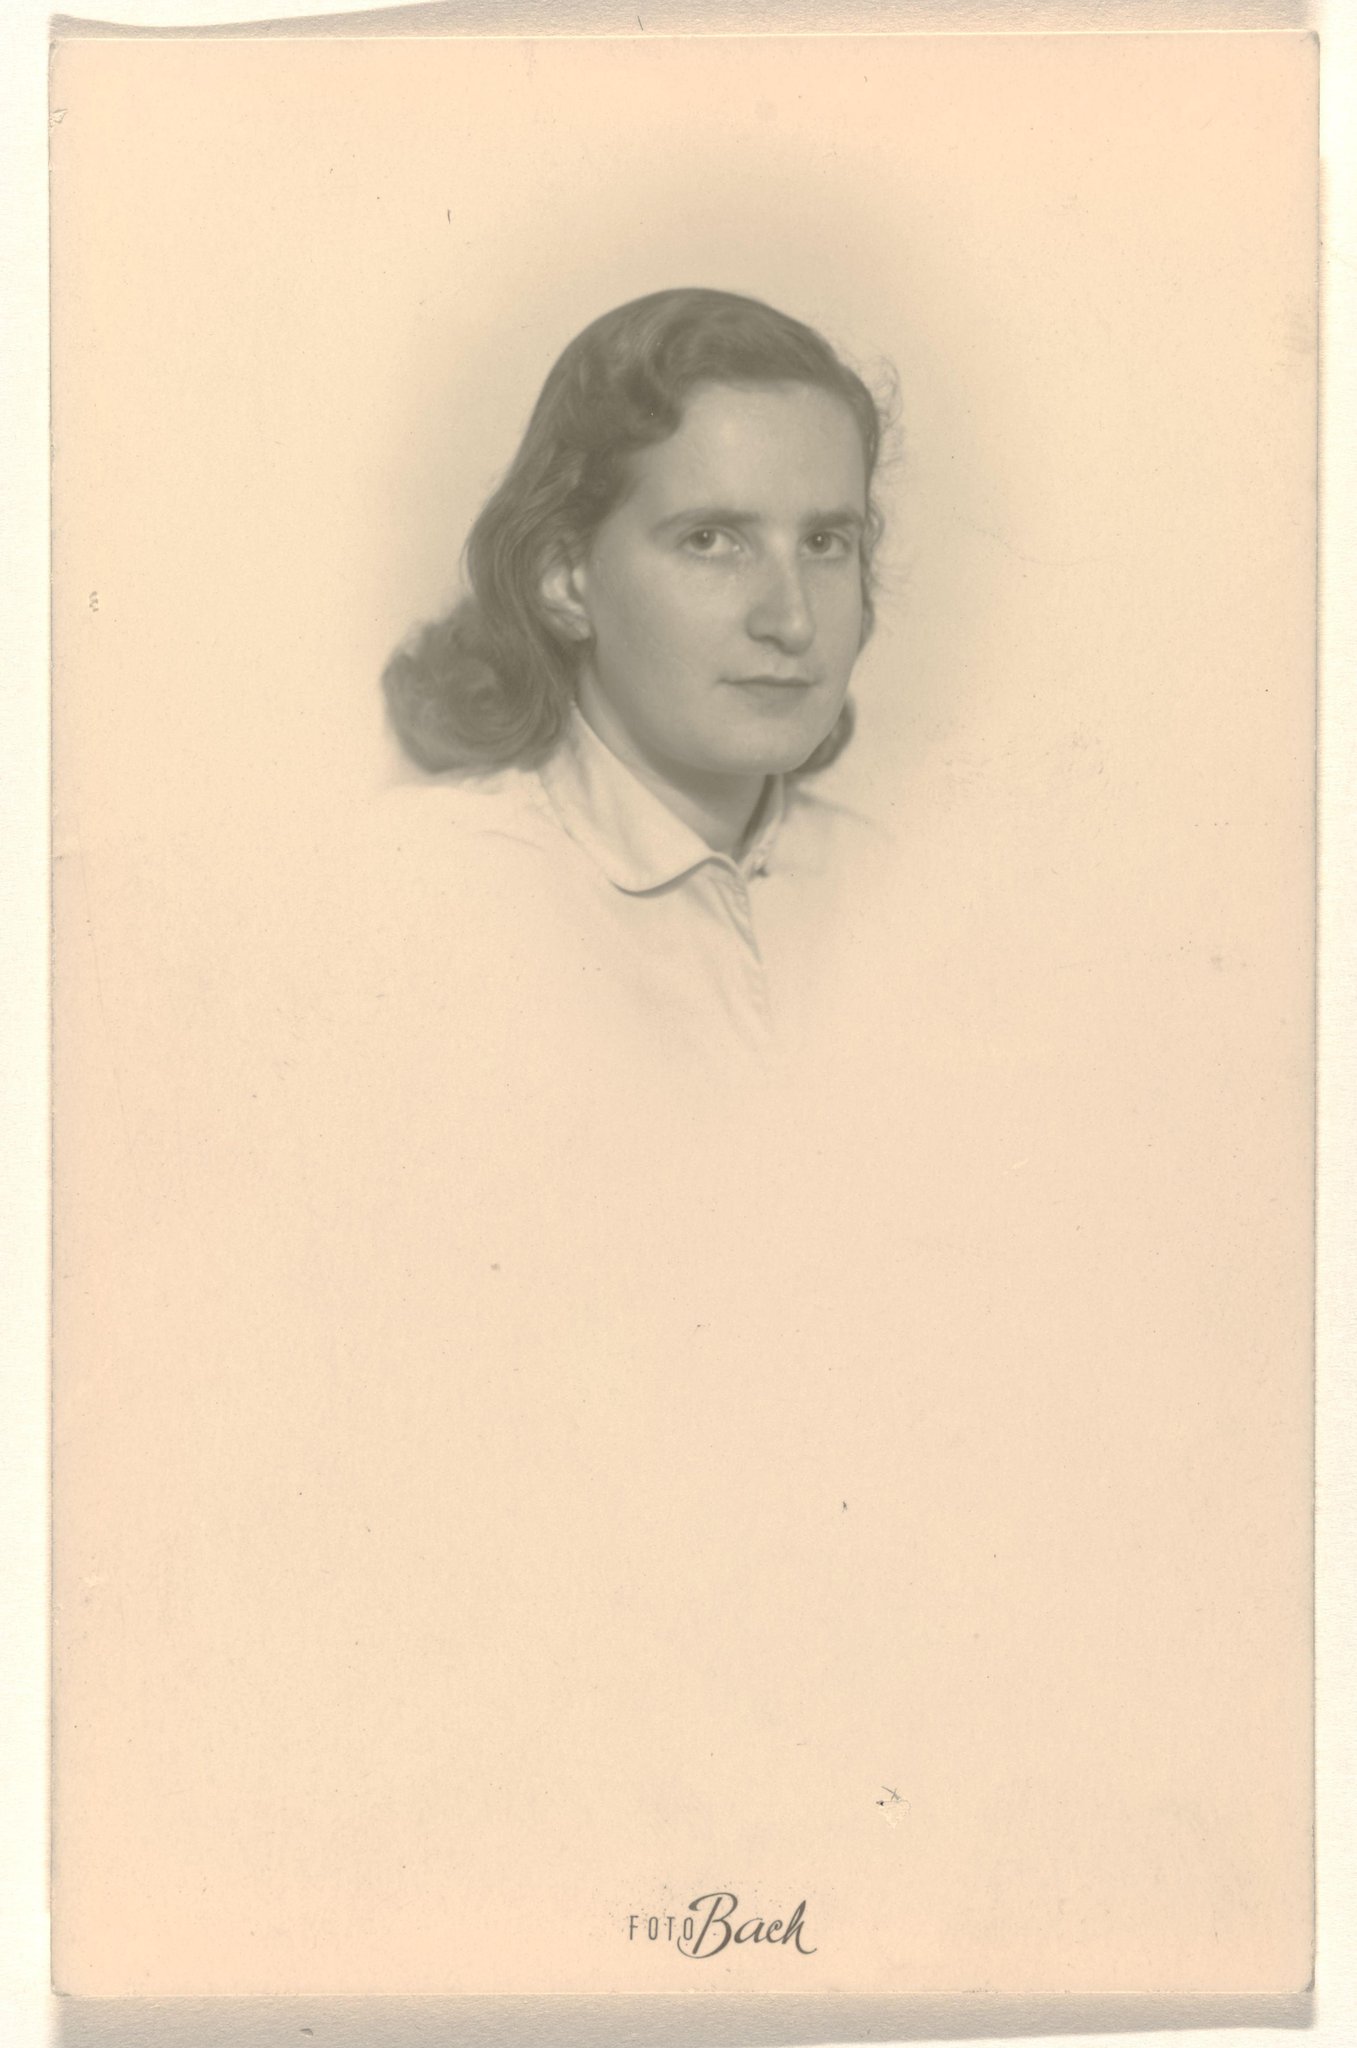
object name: photograph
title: Portret van Isabel Wachenheimer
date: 1945-1958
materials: photographic support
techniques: gelatin silver print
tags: leiden, isabel wachenheimer-elon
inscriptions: number: ‘10721’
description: Portret van Isabel Wachenheimer, als voorkant van een onbeschreven briefkaart.